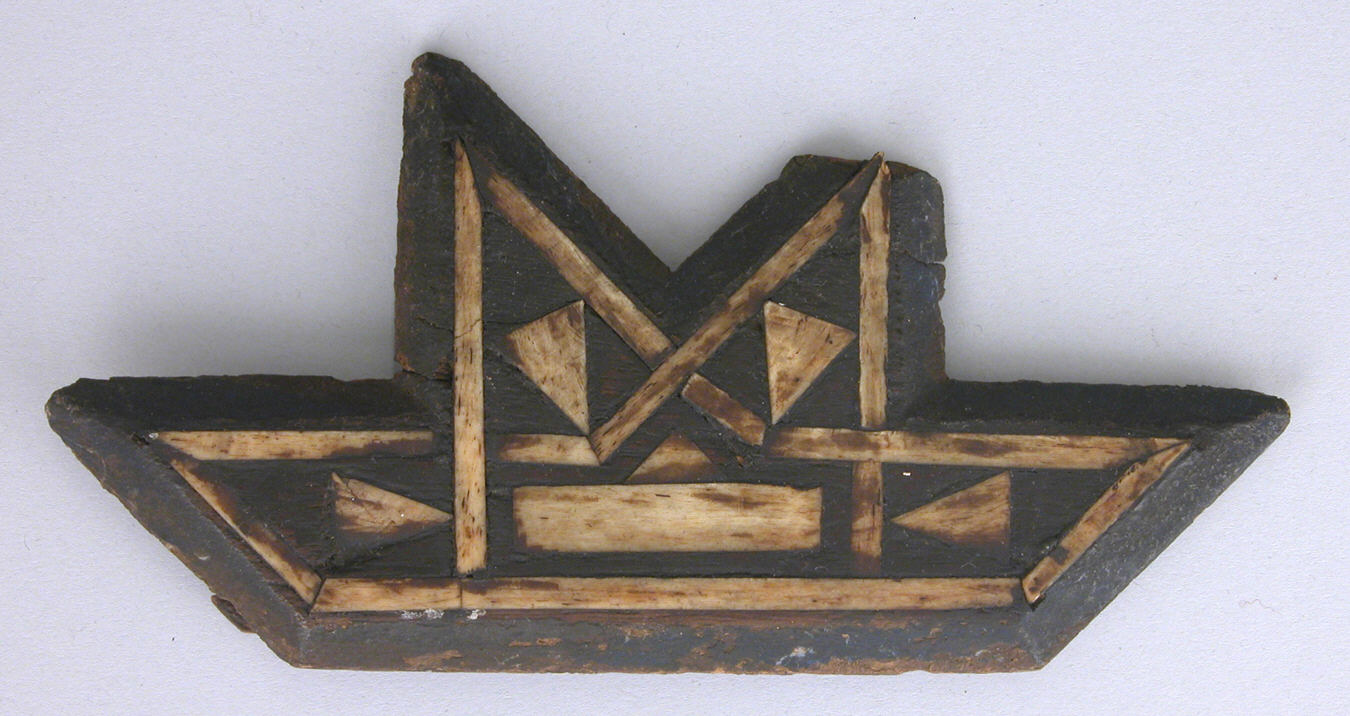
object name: panel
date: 1201-1400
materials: ivory, wood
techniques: inlay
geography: egypt